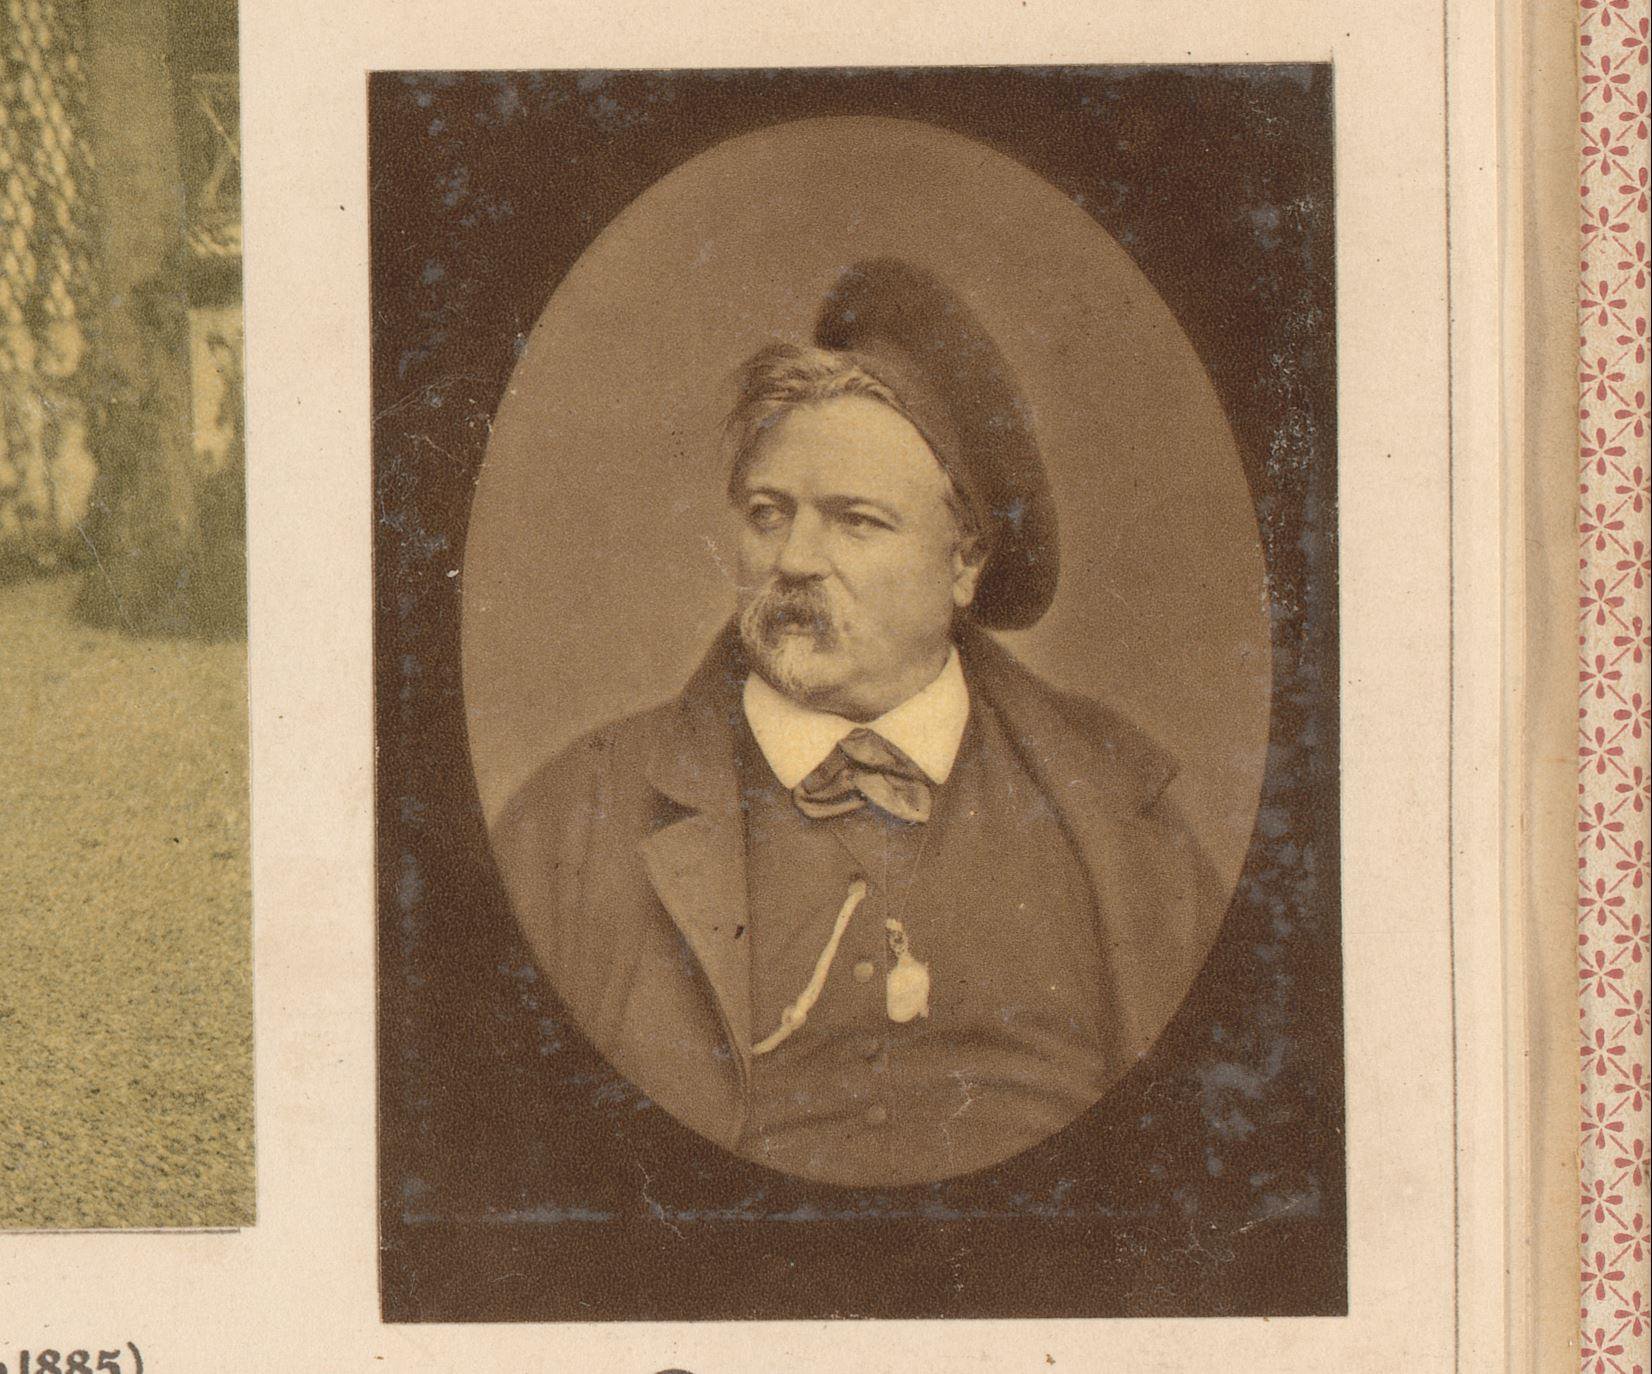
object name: photograph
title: Portret van Alfred Grévin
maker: Anonymous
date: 1887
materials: paper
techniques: rotogravure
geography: france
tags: print maker, draughtsman, alfred grévin, historical persons, artist (in general), france